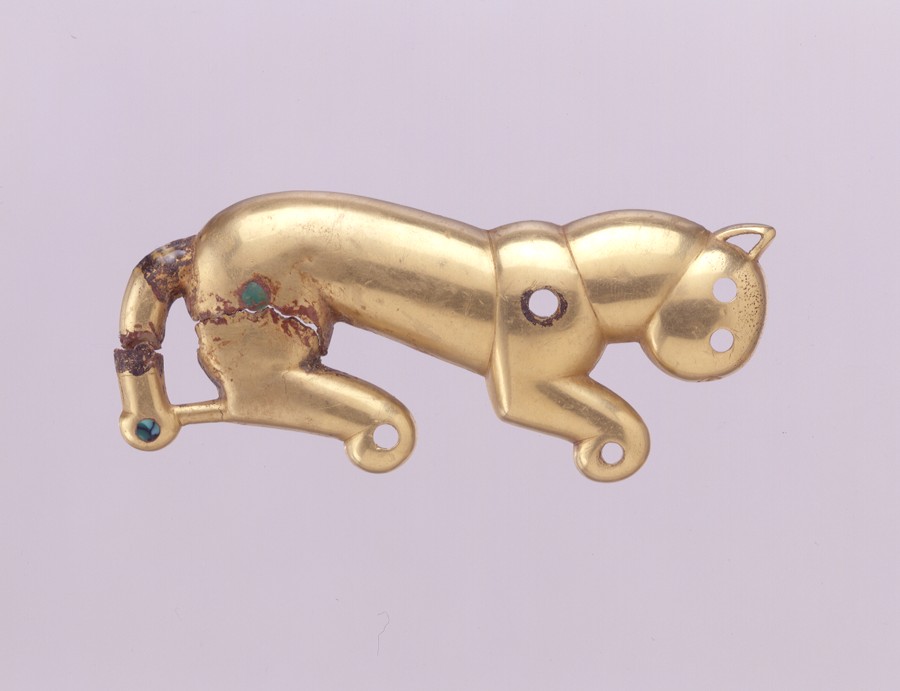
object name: pectoral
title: Pectoral in the Shape of a Leopard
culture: north chinese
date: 600-501 BCE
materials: gold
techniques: inlay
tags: leopards